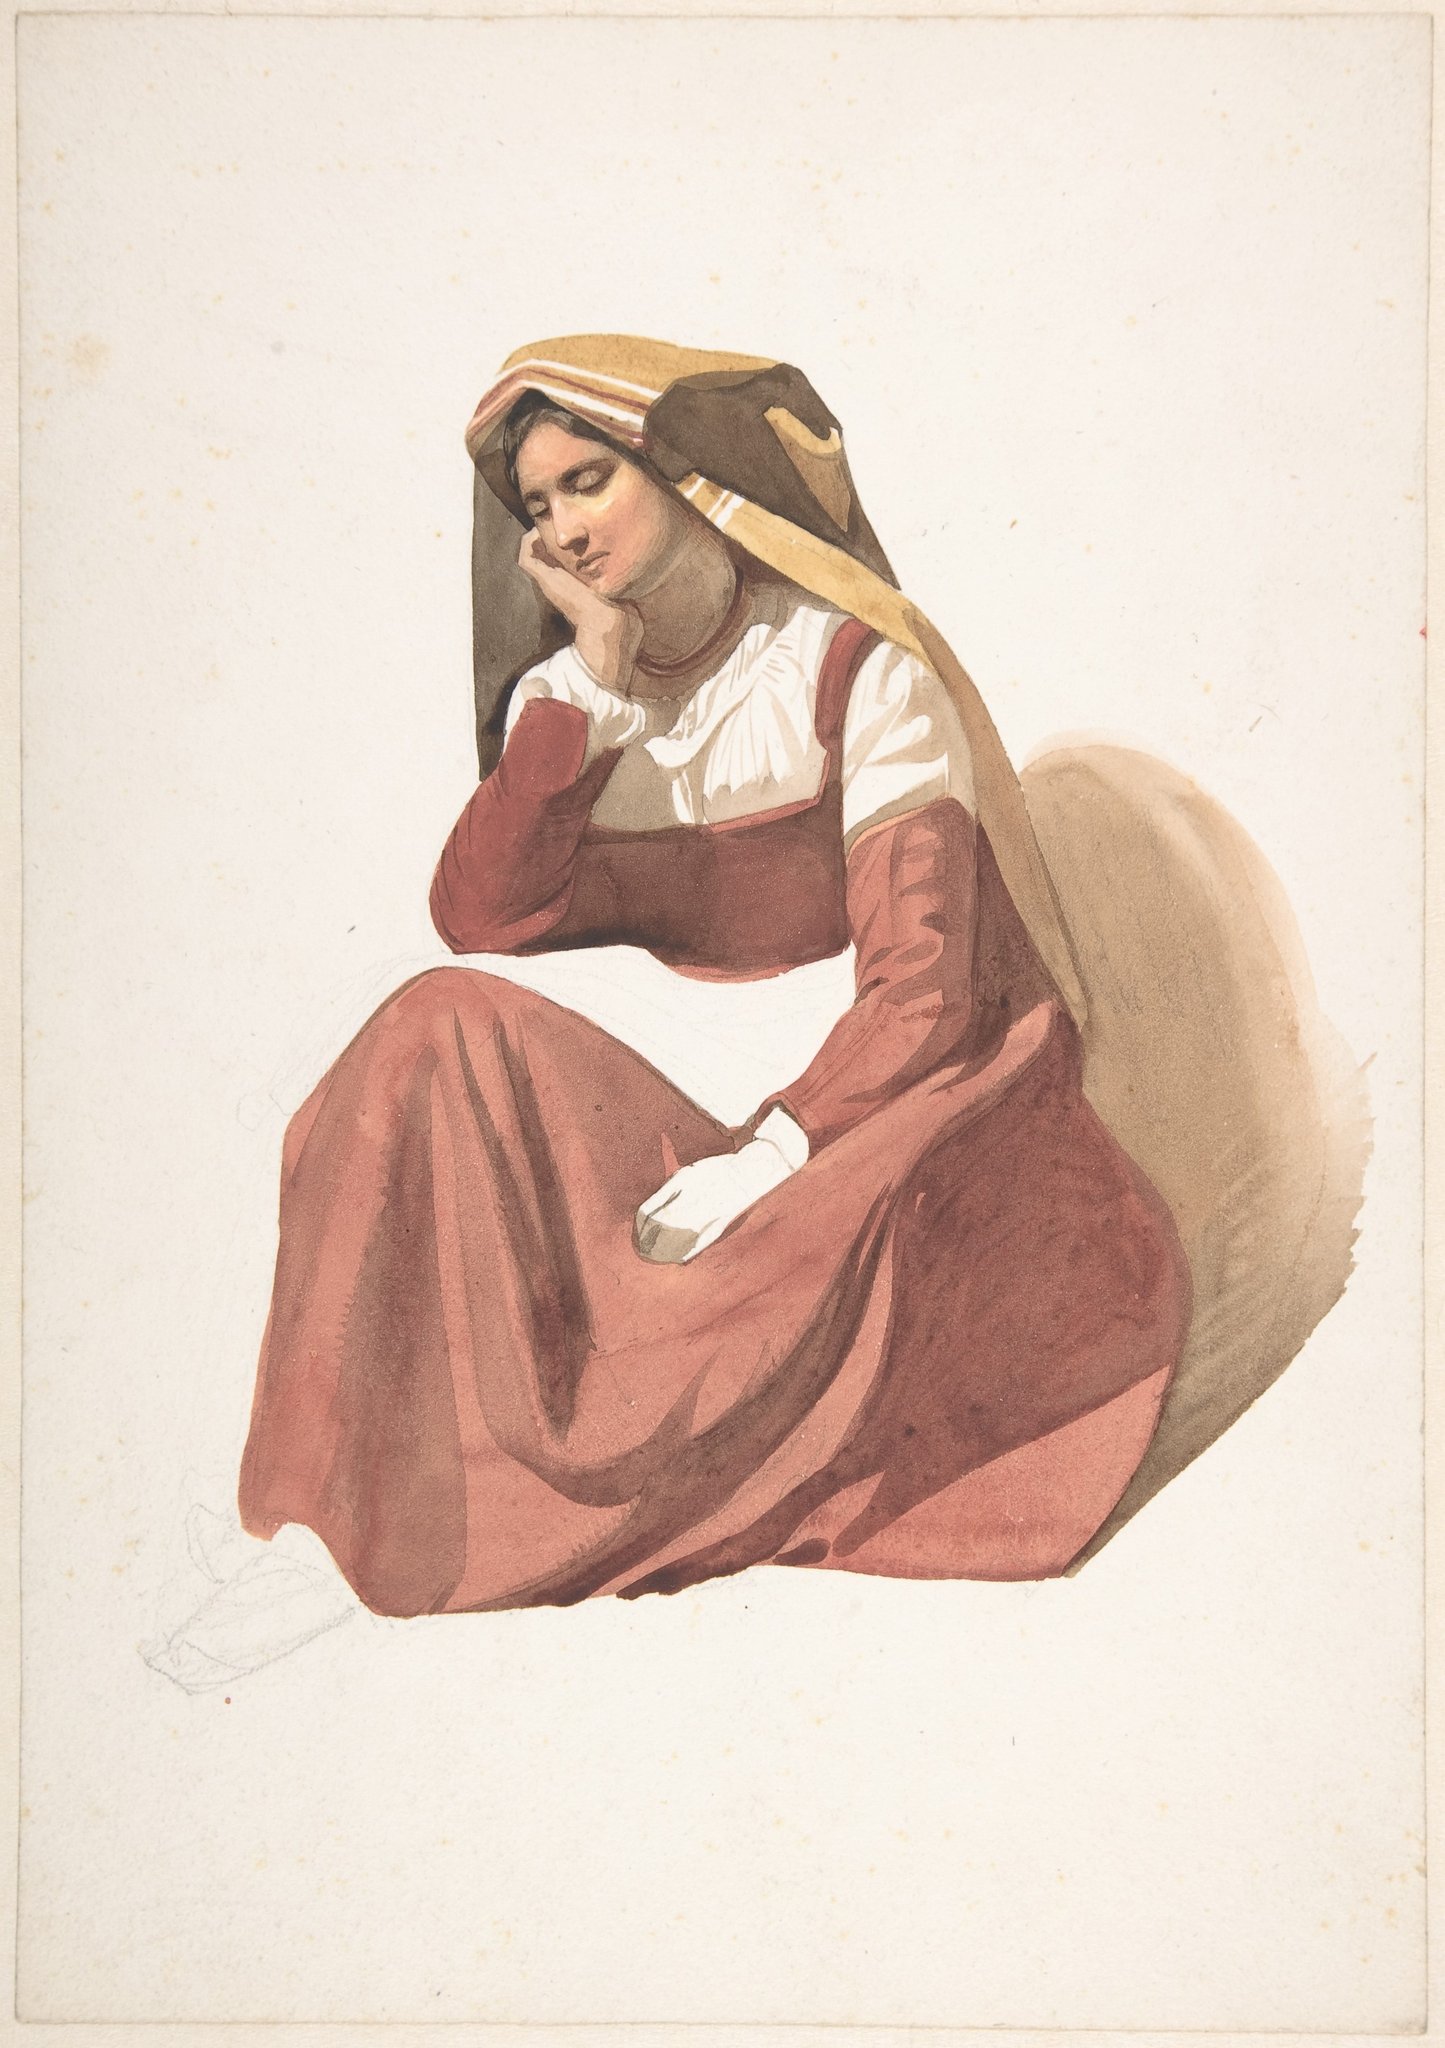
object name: drawing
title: Seated Italian Peasant Woman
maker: pierre louis dubourcq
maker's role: artist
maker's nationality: dutch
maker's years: 1815-1873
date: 1834-1866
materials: graphite, watercolor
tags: portraits,women